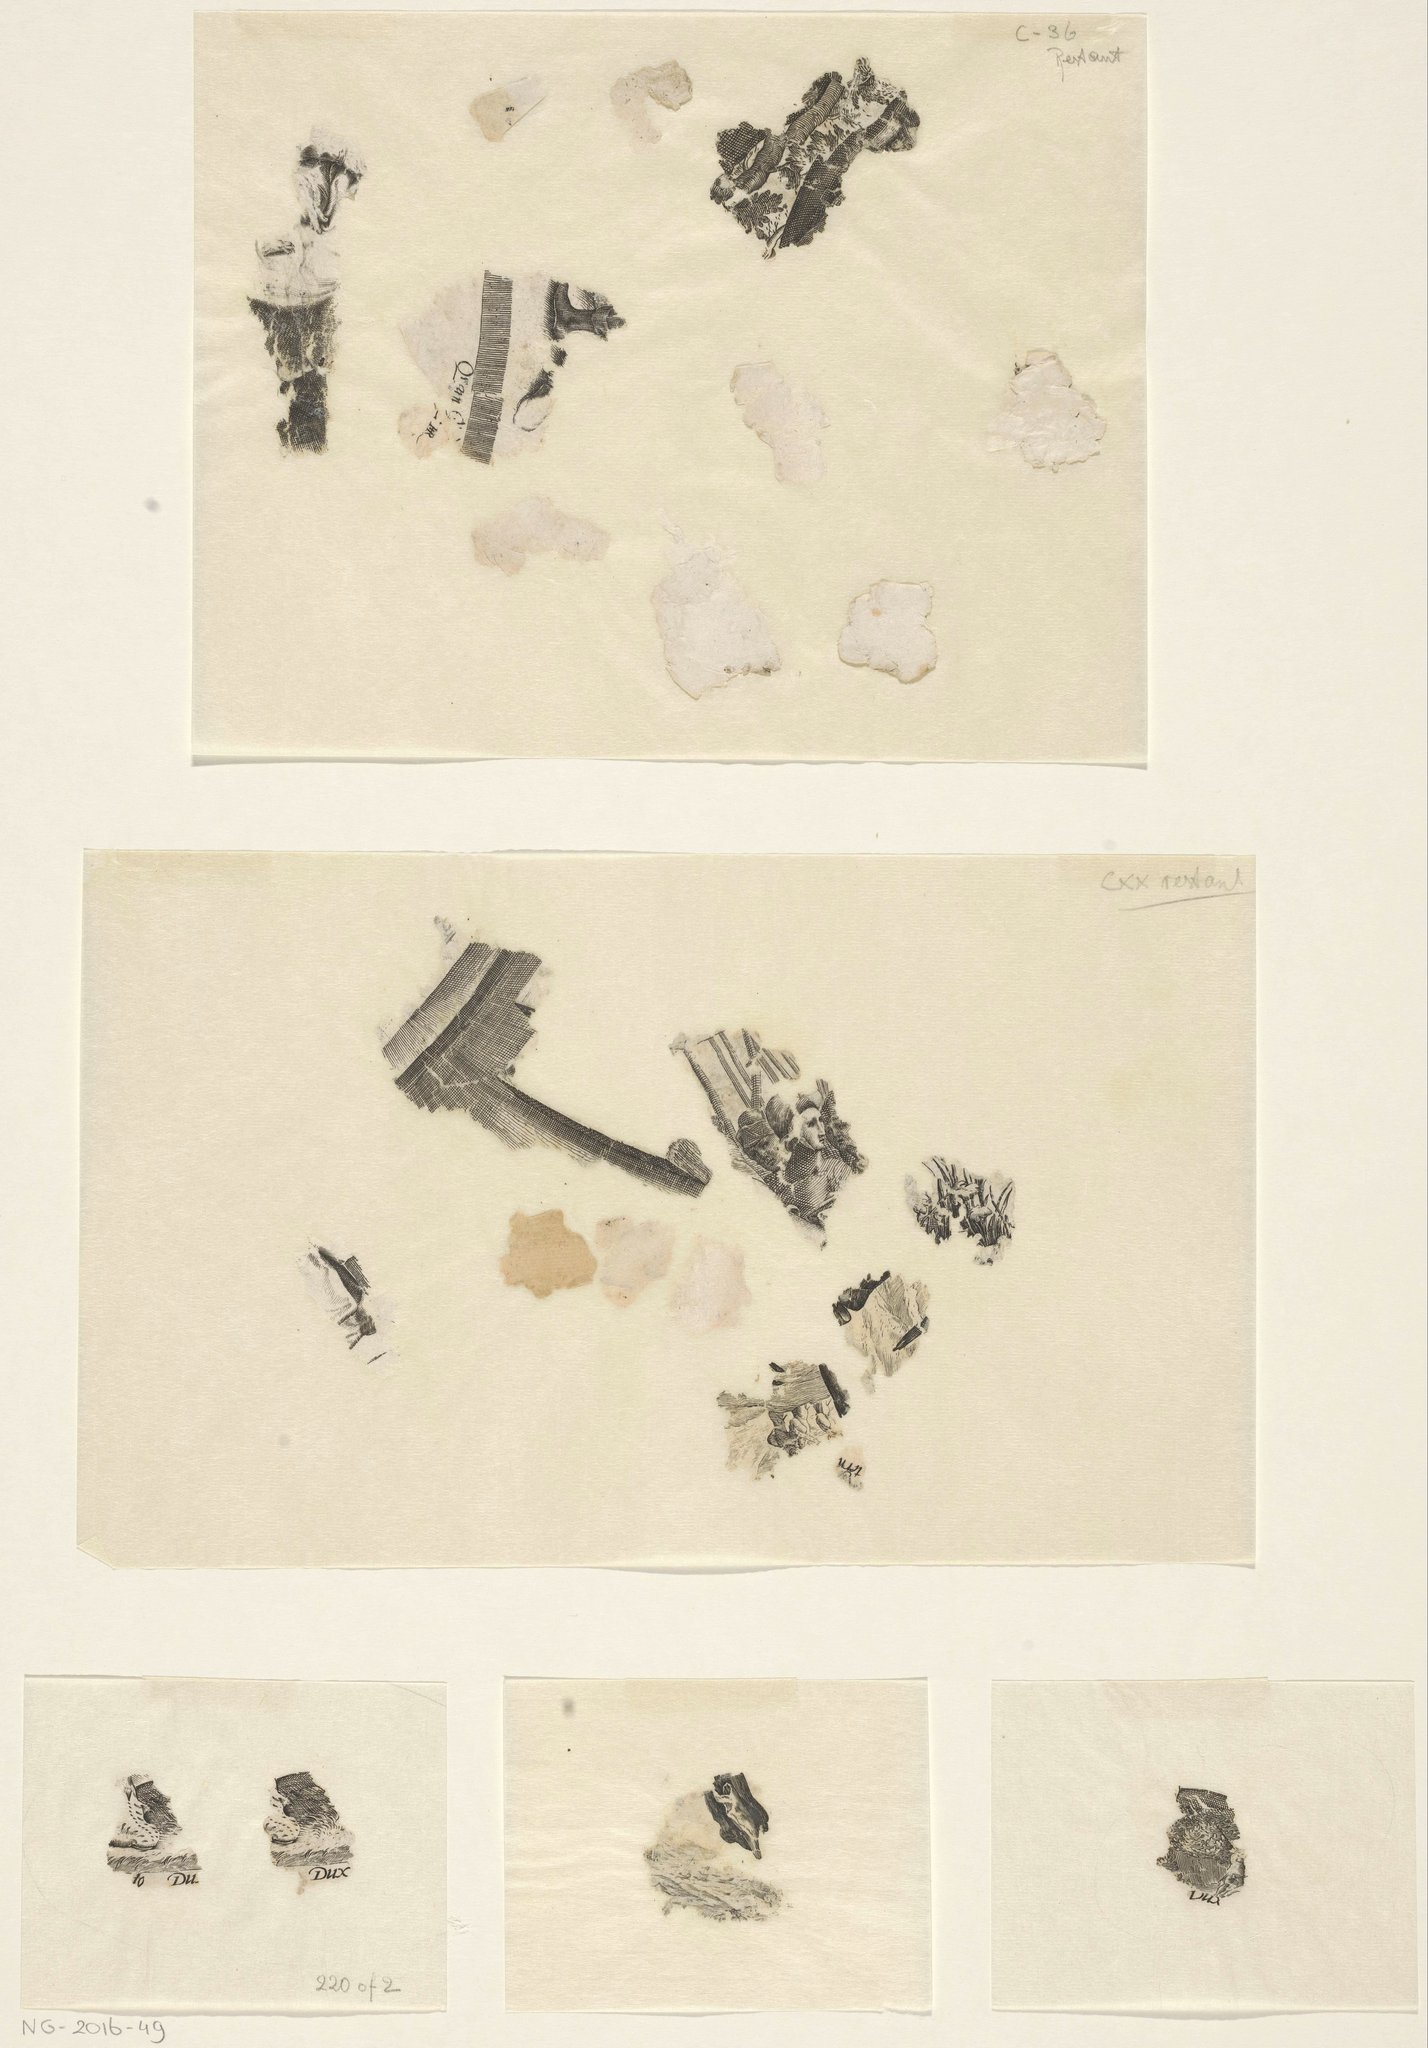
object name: print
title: Losse fragmenten van prenten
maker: Anonymous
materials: paper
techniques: engraving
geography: netherlands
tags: reis van barendsz en van heemskerck in 1596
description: De prenten in de Nova Zembla collectie zijn tijdens een expeditie van Willem Barendsz en Jacob van Heemskerk in 1596-1597 noodgedwongen in het winterkamp, het ‘Behouden Huis’, op het eiland achtergelaten. De prenten waren in één of meerdere stapels als handelswaar meegenomen vanuit Amsterdam. Bijna drie eeuwen later, in 1871, keerde de Noor Elling Carlsen terug naar Nova Zembla en vond daar de restanten van het ‘Behouden Huis, inclusief een groot deel van de inventaris. Een deel van de prenten, in de vorm van aaneengekoekte kluiten, werd toen ook teruggevonden. De papierkluiten waren soms op meerdere plekken gebroken. Tussen 1975-1979 zijn de prenten van elkaar gescheiden. Dit leverde in totaal ca. 1000 fragmenten van ca. 400 afdrukken van ca. 150 verschillende prenten op. Voor zover mogelijk zijn de fragmenten samengevoegd en zijn de prenten gereconstrueerd.